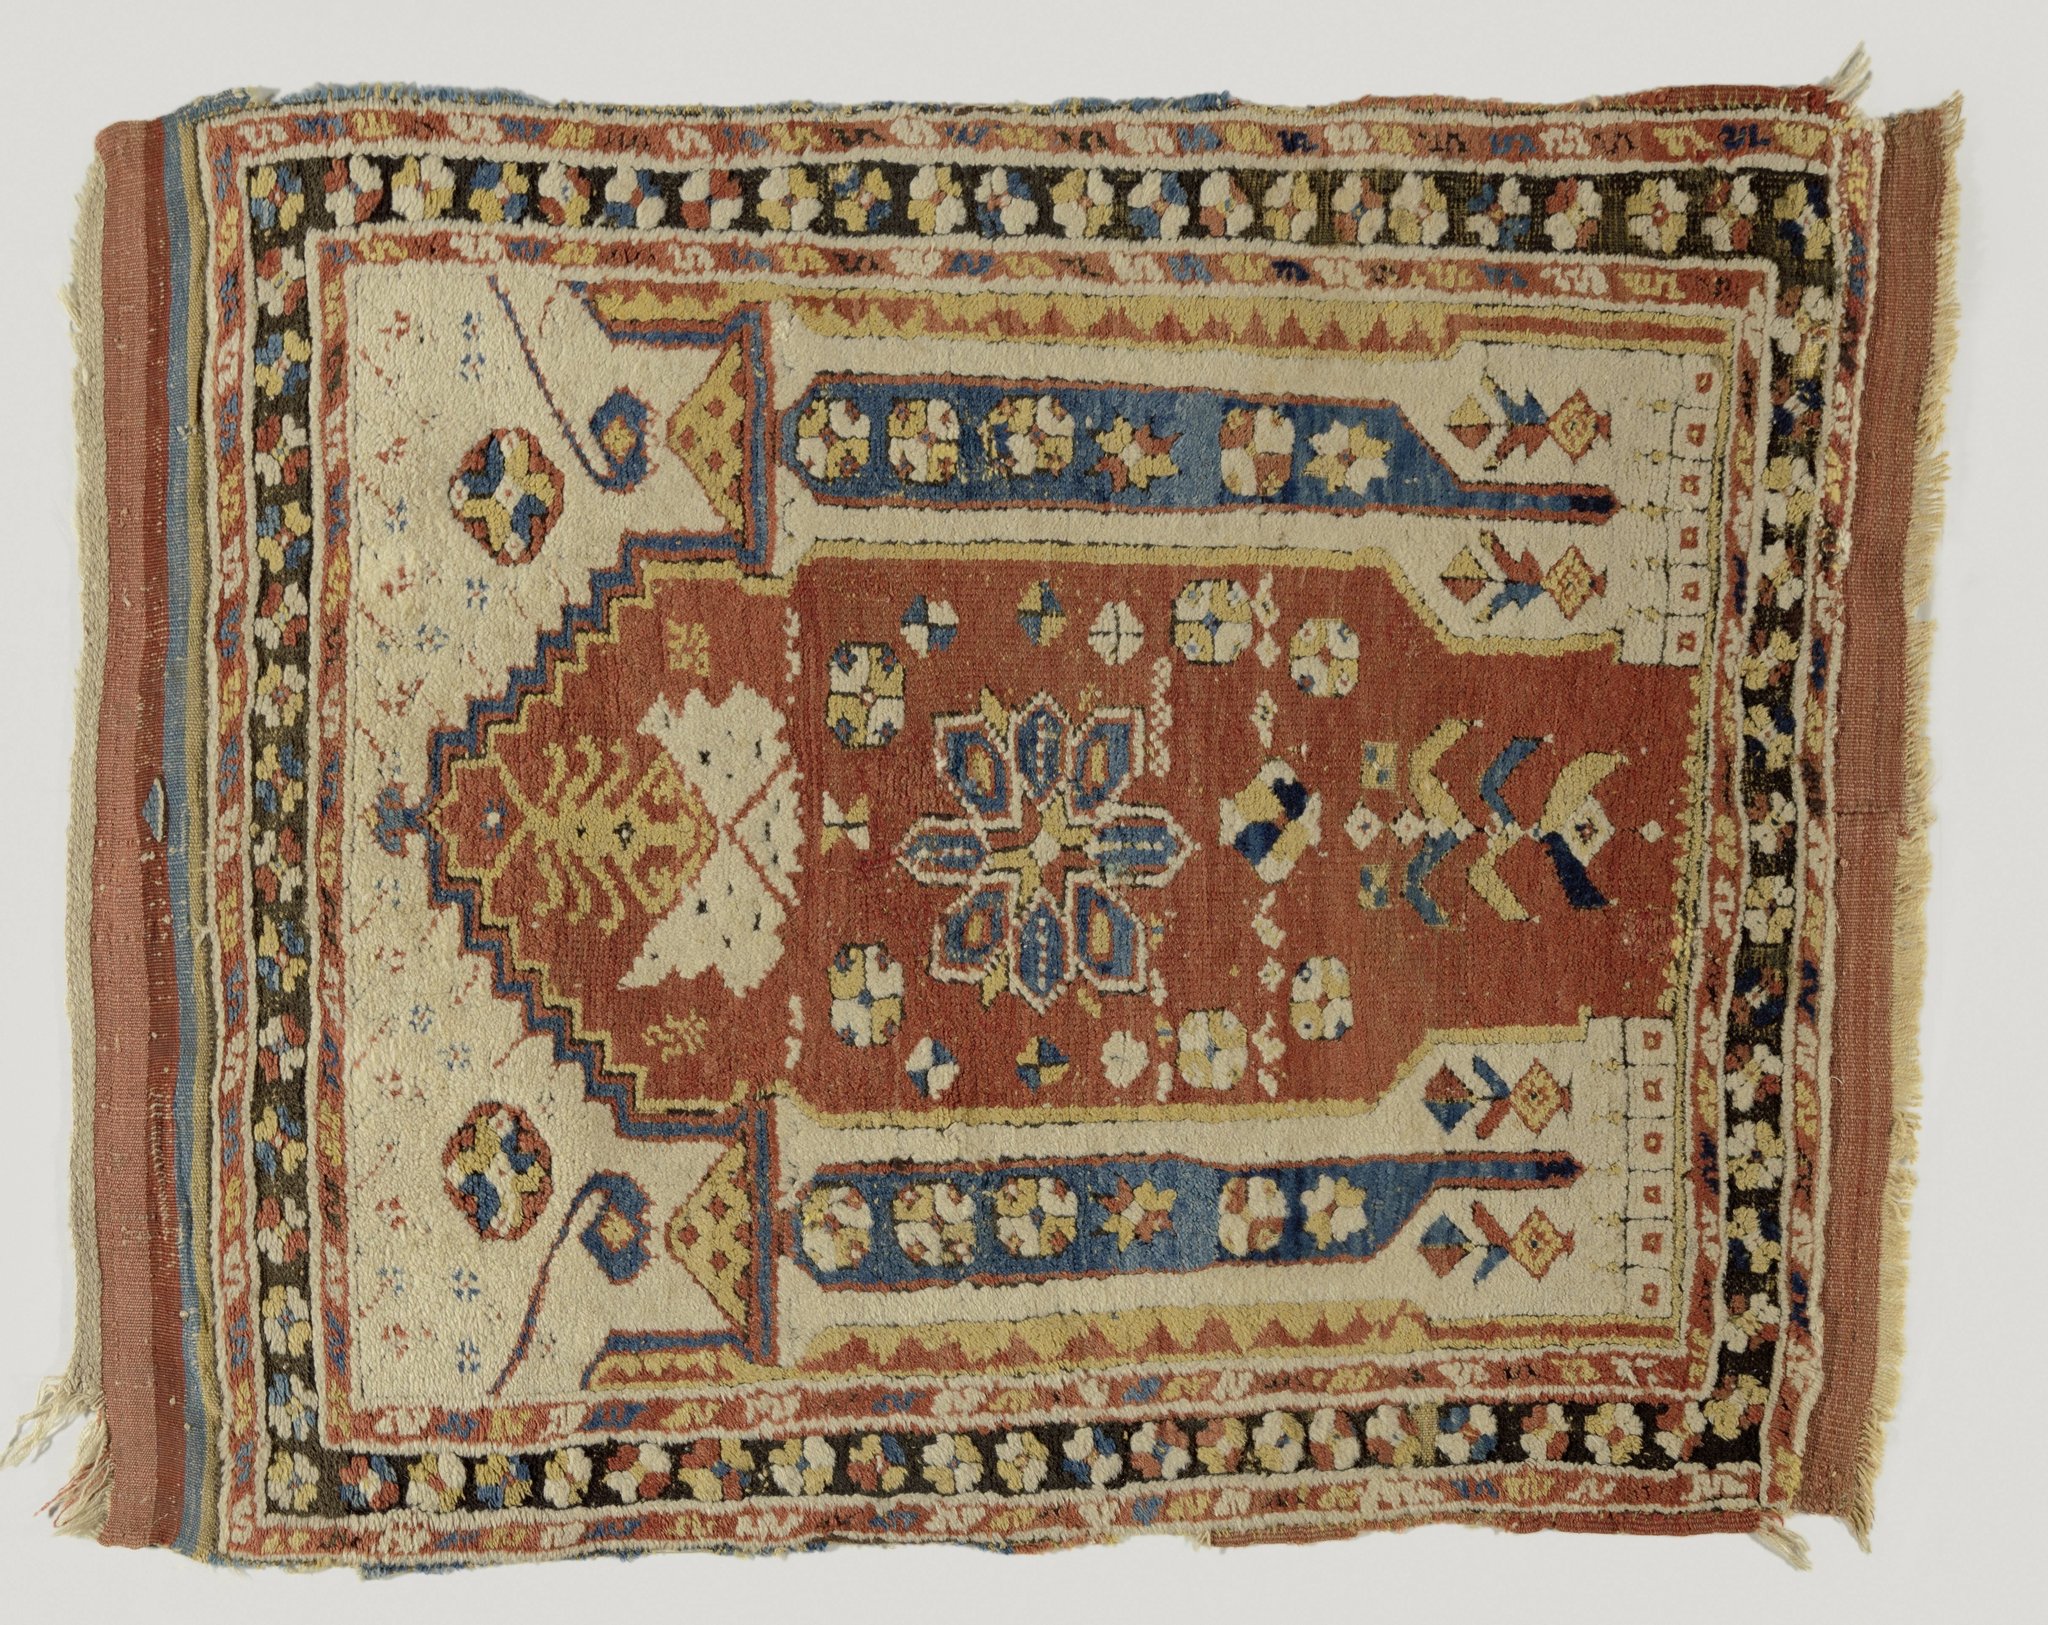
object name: oriental rug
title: Bidkleed, z.g. kolommen-bidkleed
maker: Anonymous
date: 1850-1900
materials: wool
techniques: ghiordes knot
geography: konya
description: Bidkleed, z.g. kolommen-bidkleed. Middenveld: terracotta mihrab met driehoekige trapgeveltop, waarin een grote anjelier in wit hantgt en in het midden een blauwe rozet en strooigoed staan. Vier witte kolommen omgeven twee blauwe zijnissen. De zwikken zijn wit. Randen: drievoudig. Een vrij smalle hoofdrand in bruin-zwart met losse kleurige rozetten is gevat in twee gelijke zomen van terracotta met S-ssen. Baard: onderaan een fletsrode en bovenaan een geel, blauw, terra en fletsrood gestreepte baard, resp. 5 en 8 cm breed. wit, blauw, oranje en bruin, binnen effen biezen.